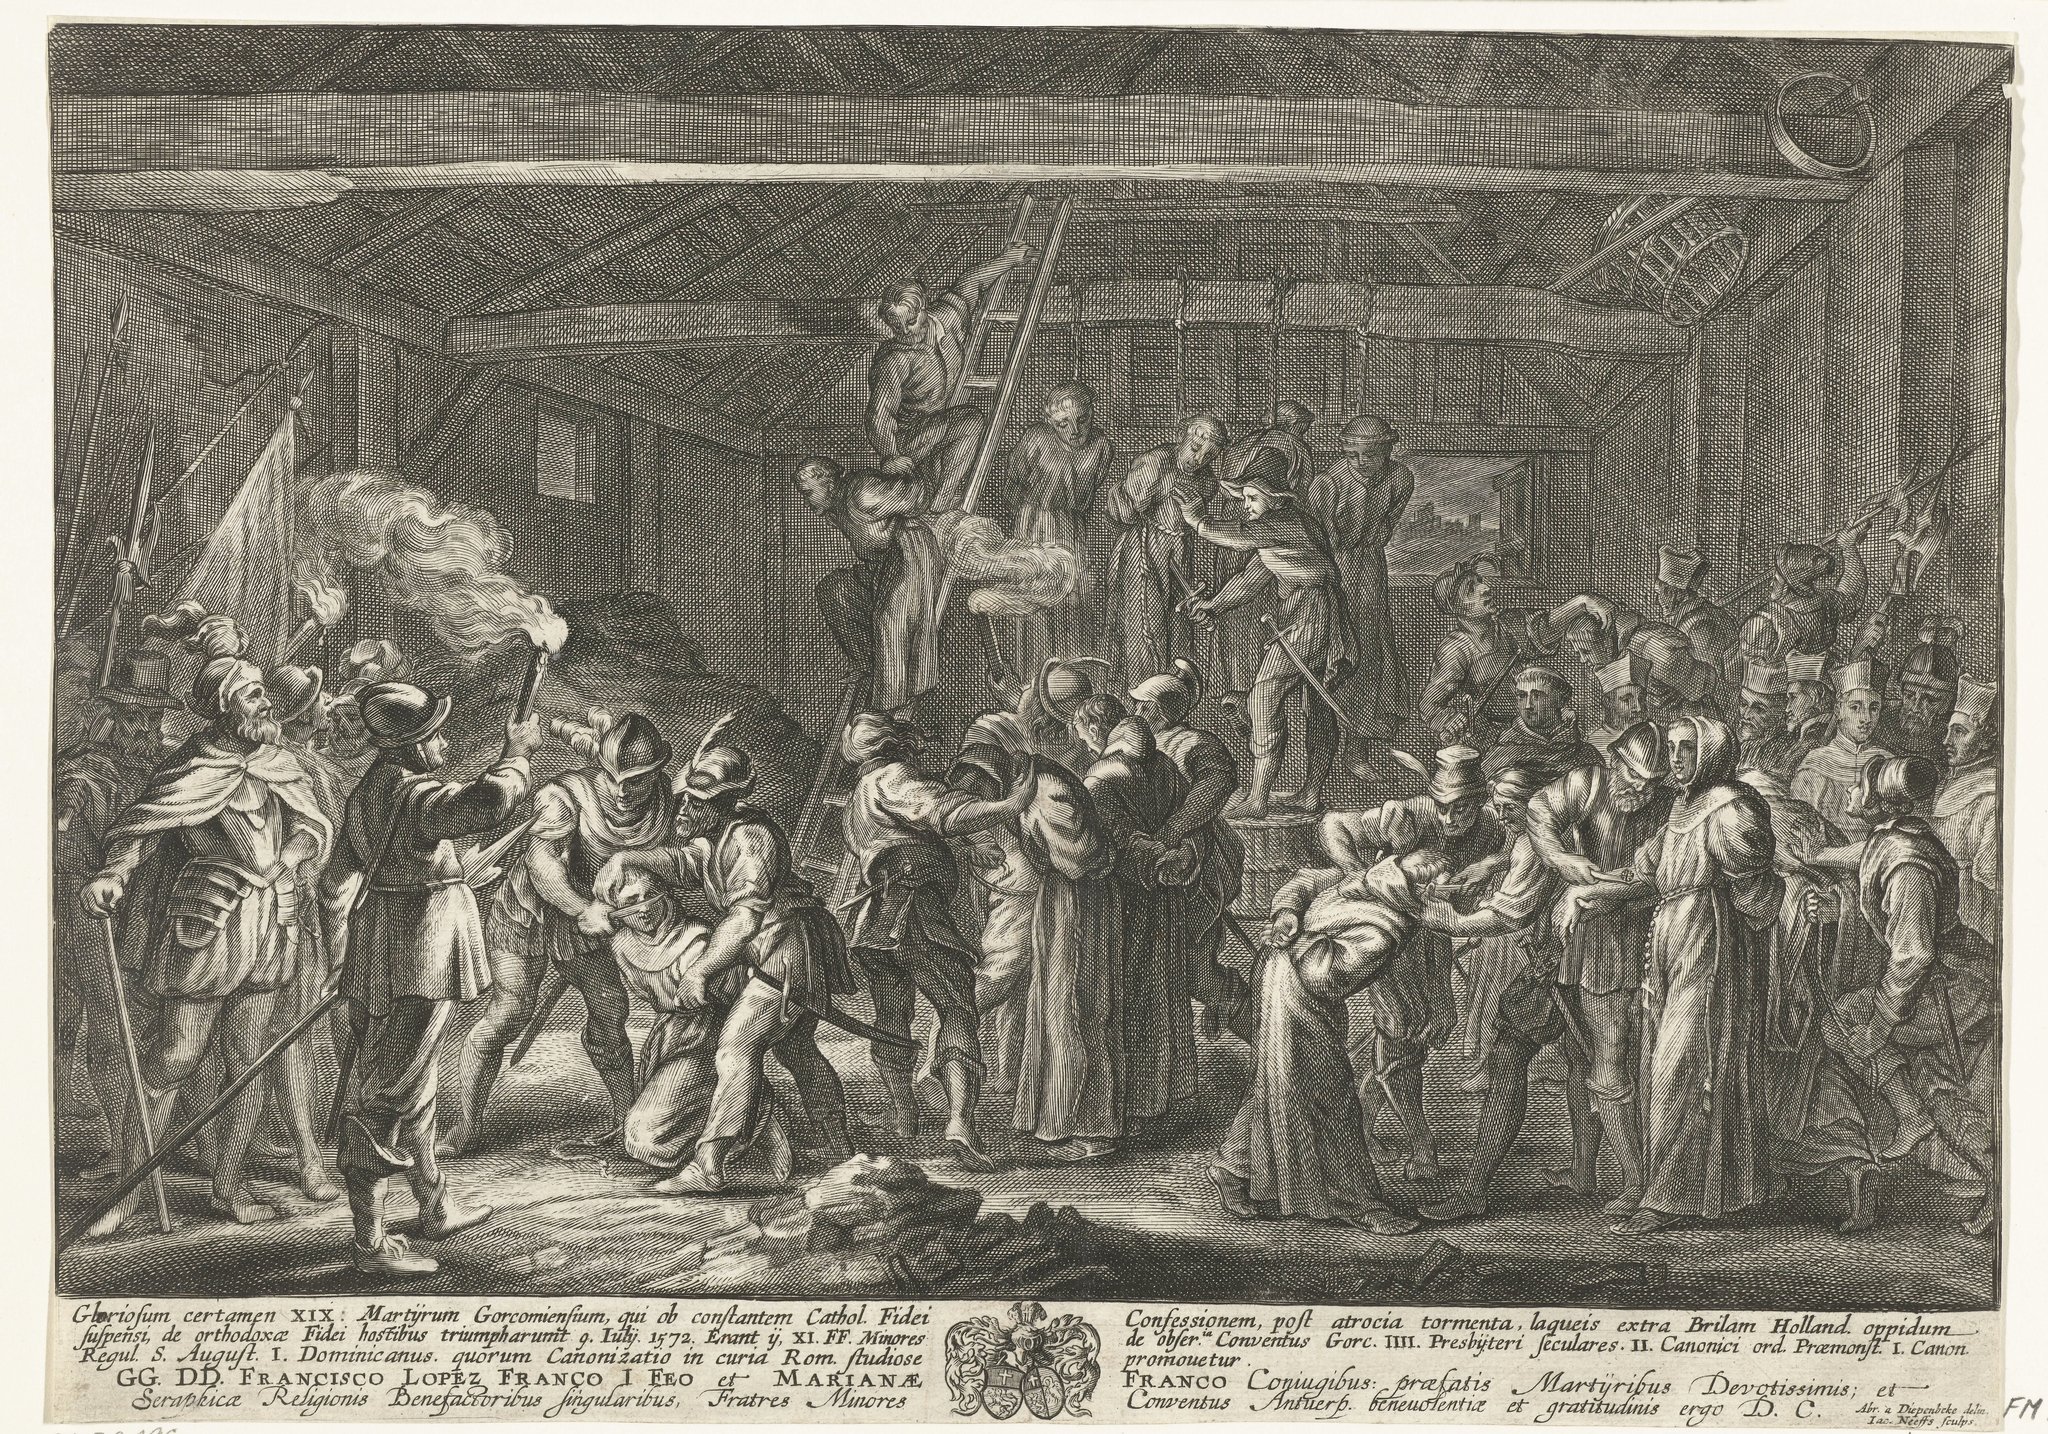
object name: print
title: Martelaren van Gorkum, 1572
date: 1620-1660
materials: paper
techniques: engraving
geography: southern netherlands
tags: nineteen friars of different orders are taken prisoner and hanged by 'watergeuzen' (beggars of the sea) after the capture of gorkum (in holland), brielle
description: Wreedheden bedreven aan de martelaren van Gorkum, 9 juli 1572. In de turfschuur te Den Briel worden de monniken en priesters door de watergeuzen gemarteld, hun neuzen en oren worden afgesneden en zij worden opgehangen aan de balken. Met onderschrift van 5 regels in het Latijn. Onder de voorstelling de wapens van het echtpaar Franco aan wie de prent is opgedragen.